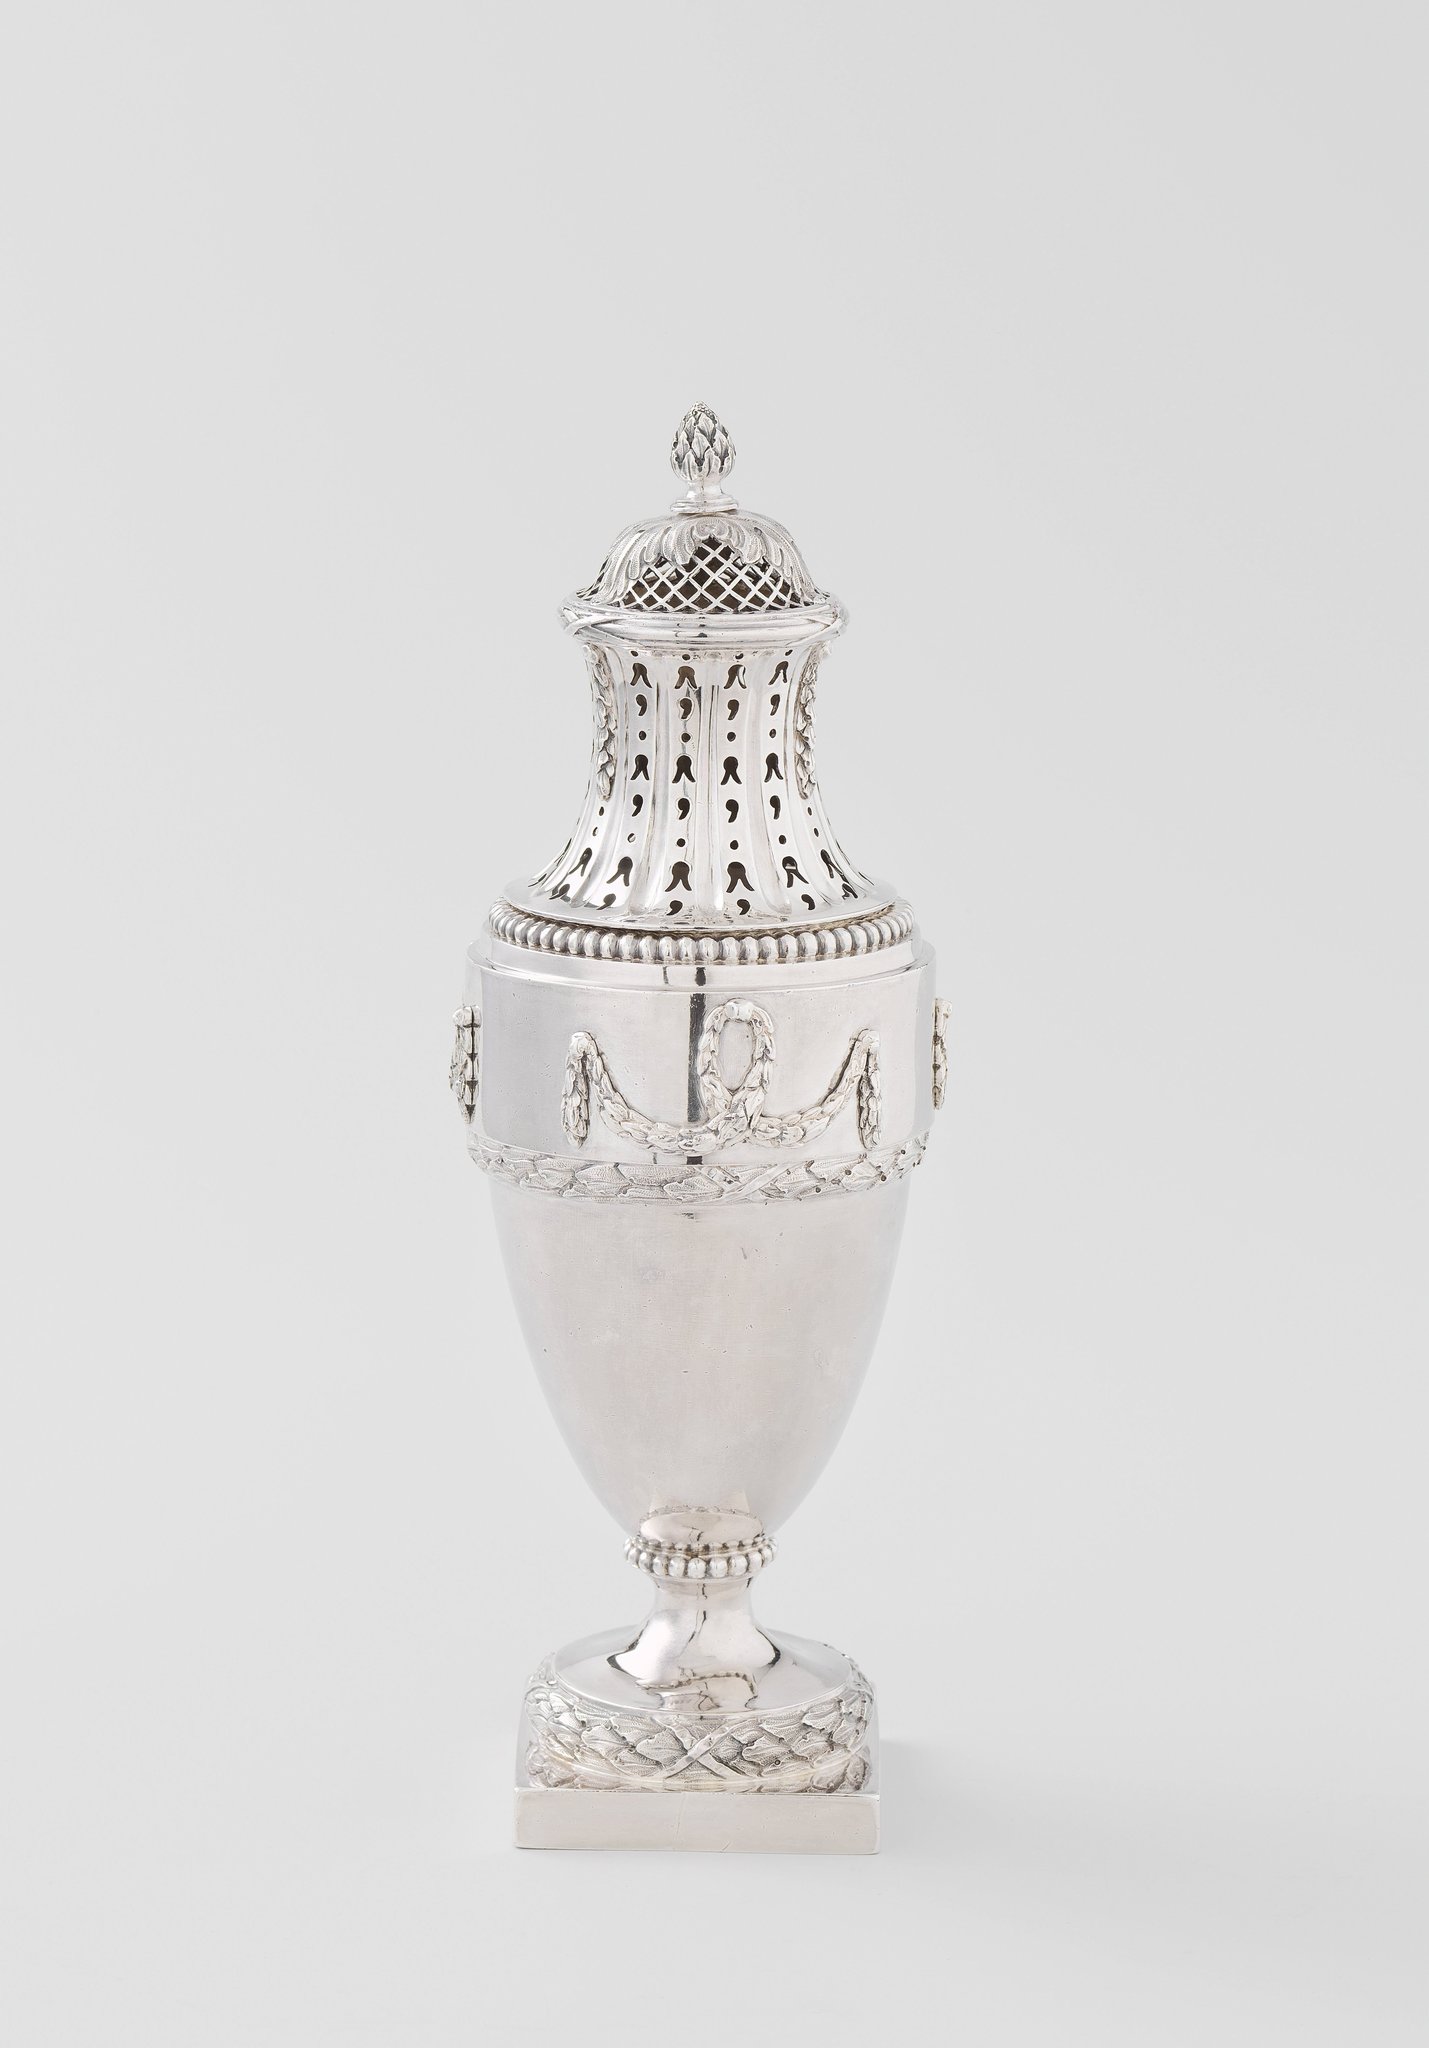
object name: strooibus, strooier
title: Pair of casters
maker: dirk evert grave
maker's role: silversmith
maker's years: 1735-1795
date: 1778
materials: silver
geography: amsterdam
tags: fruits: pine-cone, ornament ~ festoon, garland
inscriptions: alloy mark, town mark, date letter: ‘T’, maker's mark, duty mark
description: The shape and decoration of these sugar casters are derived from Classical antiquity. The holes through which the sugar was sprinkled are cleverly incorporated in the ornamentation of the cap. The sugar was sprinkled over fruit and desserts.